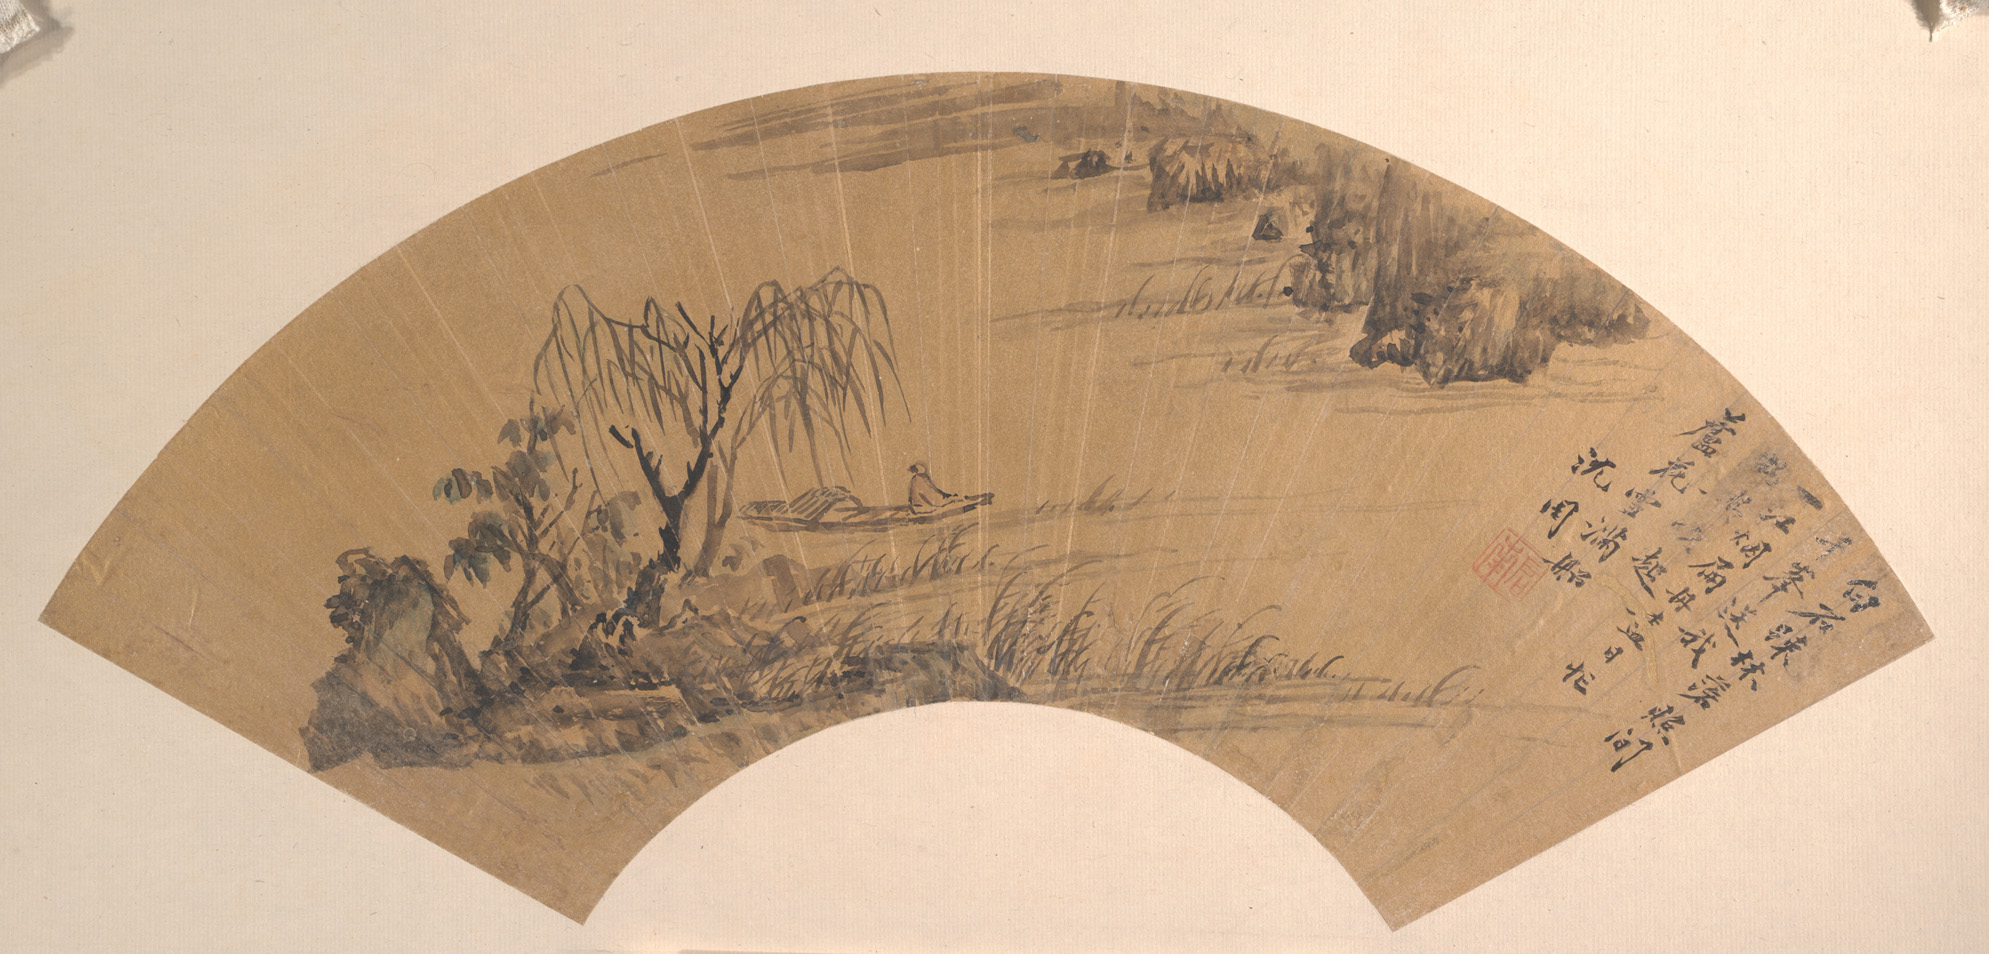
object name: folding fan mounted a an album leaf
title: Landscape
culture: chinese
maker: unidentified artist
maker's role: artist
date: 1501-1600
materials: gold, ink, paper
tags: landscapes,boats